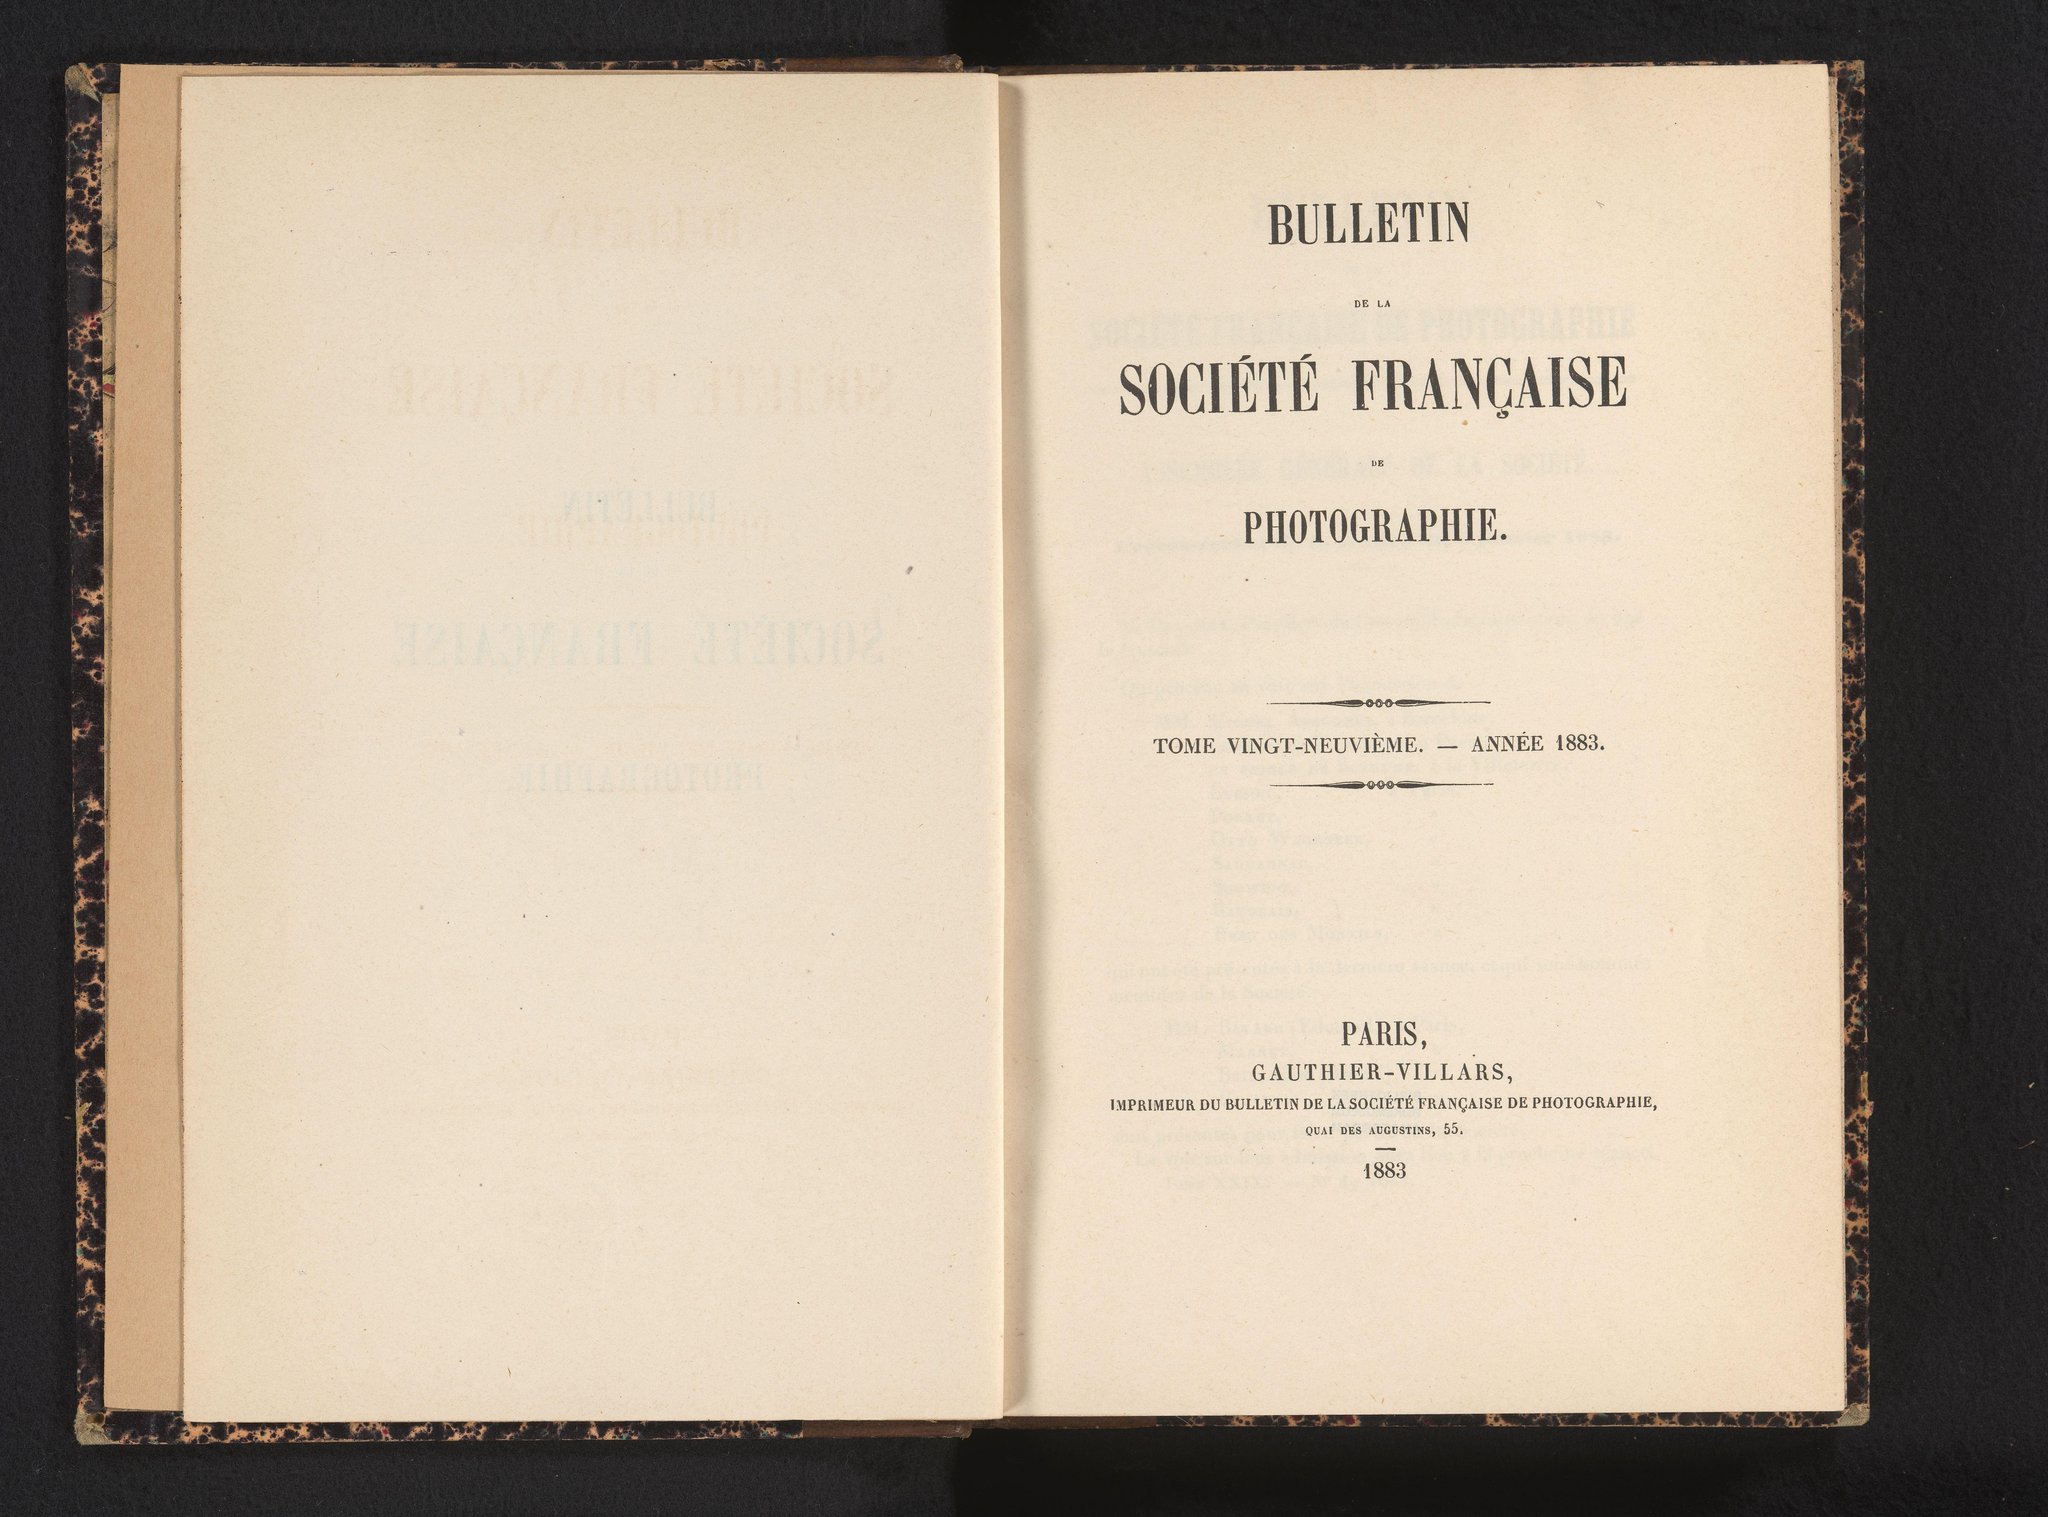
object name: book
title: Bulletin de la Société française de photographie. Tome vingt-neuvième - année 1883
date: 1883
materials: paper, cardboard, leather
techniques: letterpress printing, marbling, photoaquatint, marbled paper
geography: paris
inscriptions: number: ‘29’